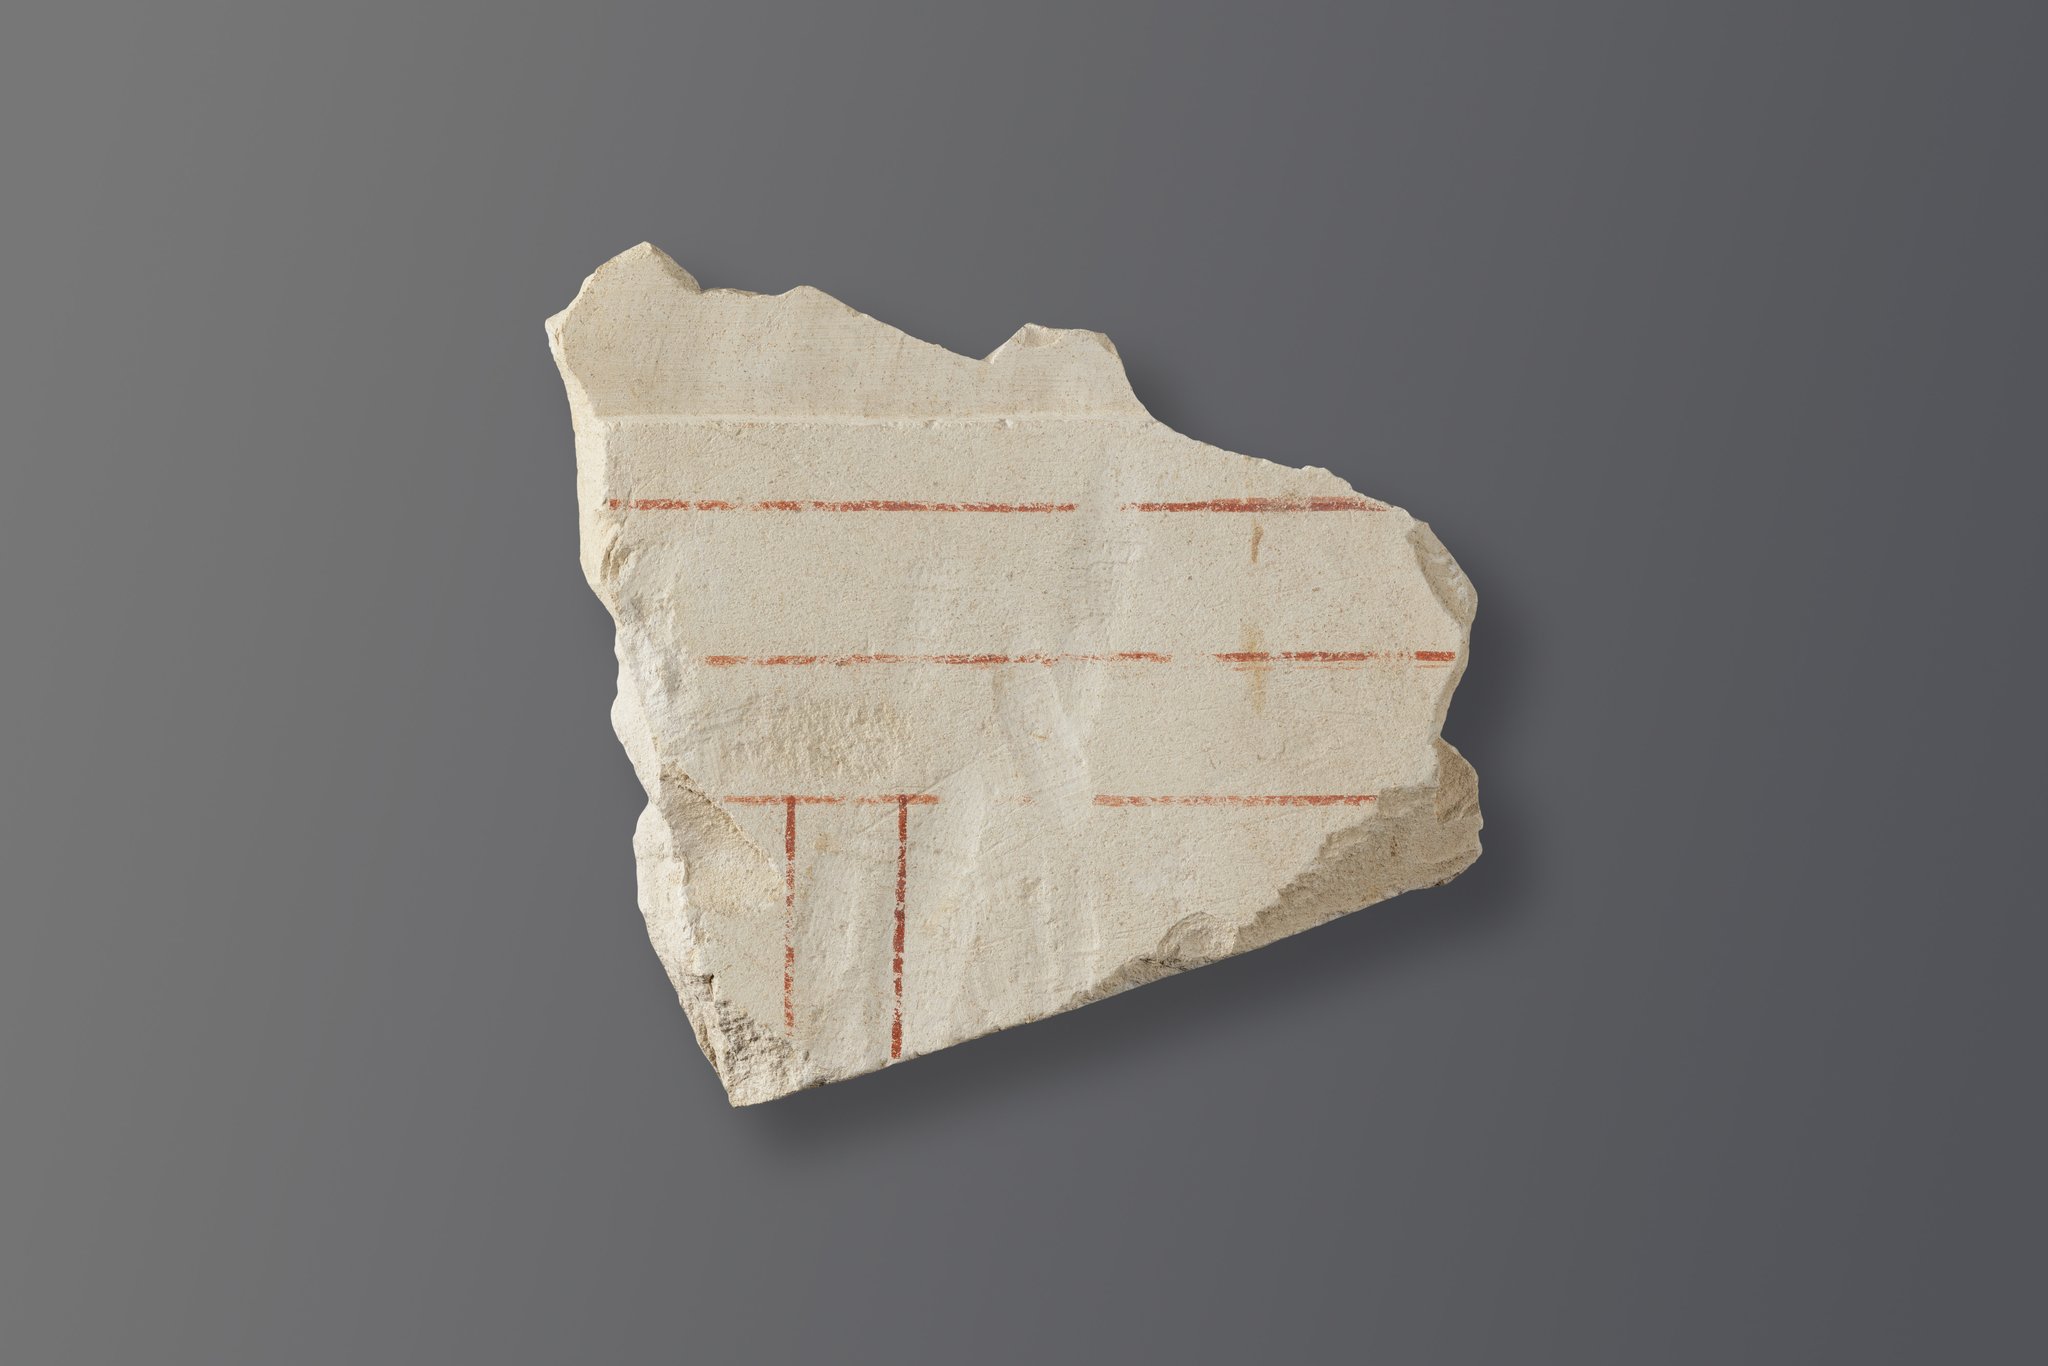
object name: relief drawing, sebeknakhte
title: Preliminary drawing for a relief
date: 2124-1504 BCE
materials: limestone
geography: egypt